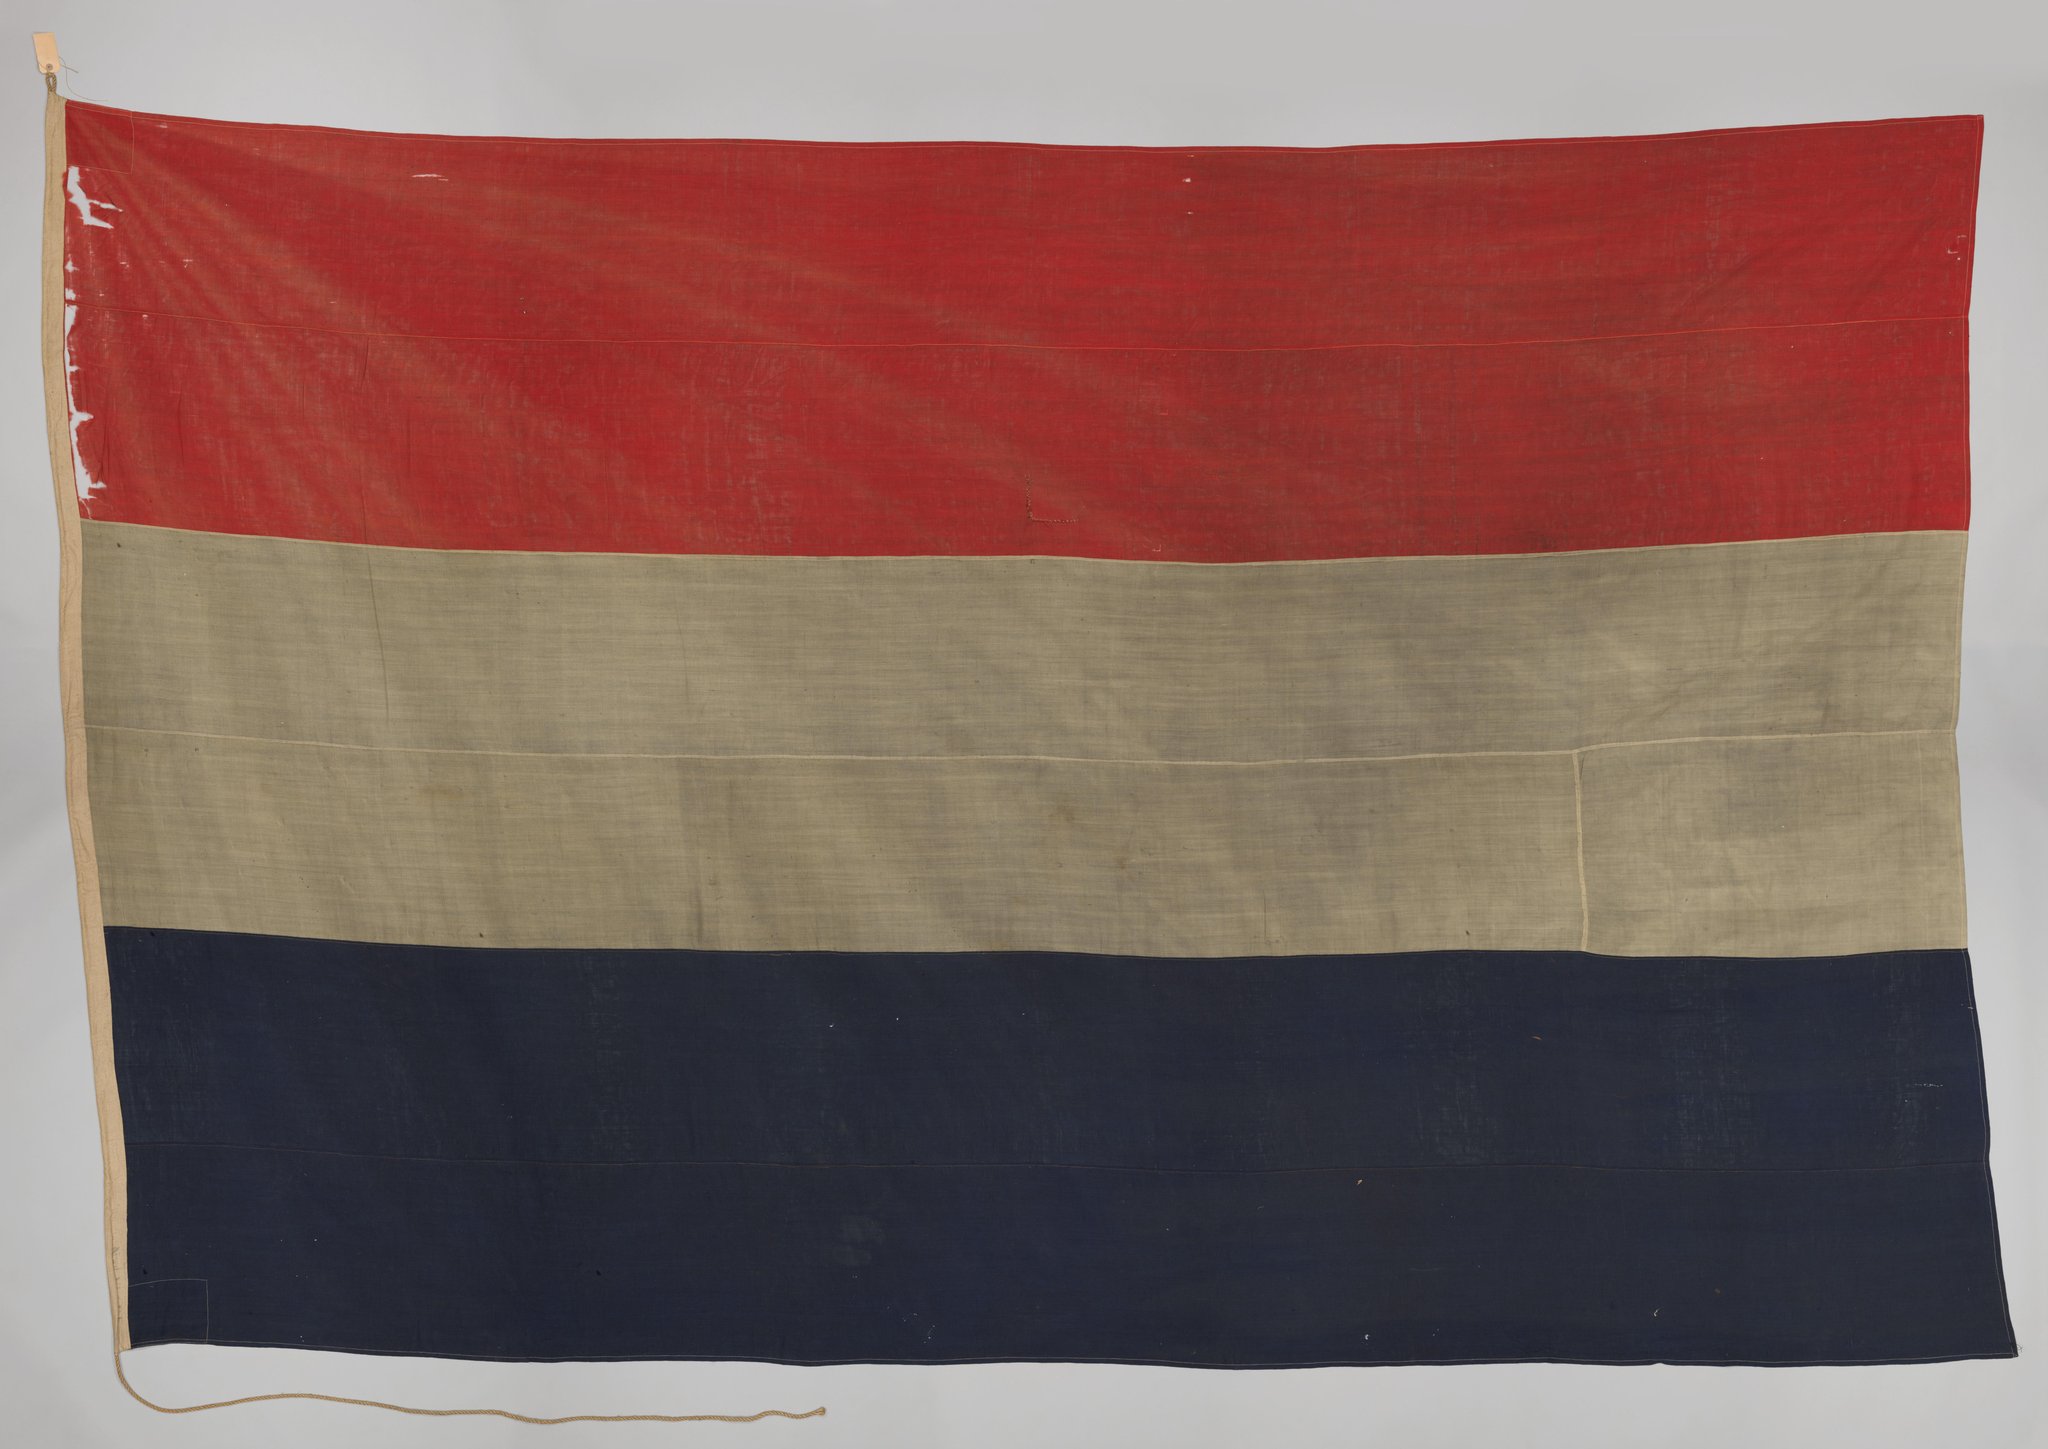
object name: flag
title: Scheepsvlag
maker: Anonymous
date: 1800-1890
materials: wool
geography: netherlands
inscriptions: : ‘NED VL 6 KL’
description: Drie banen rood-wit-blauw. Opschrift: NED VL 6 KL.